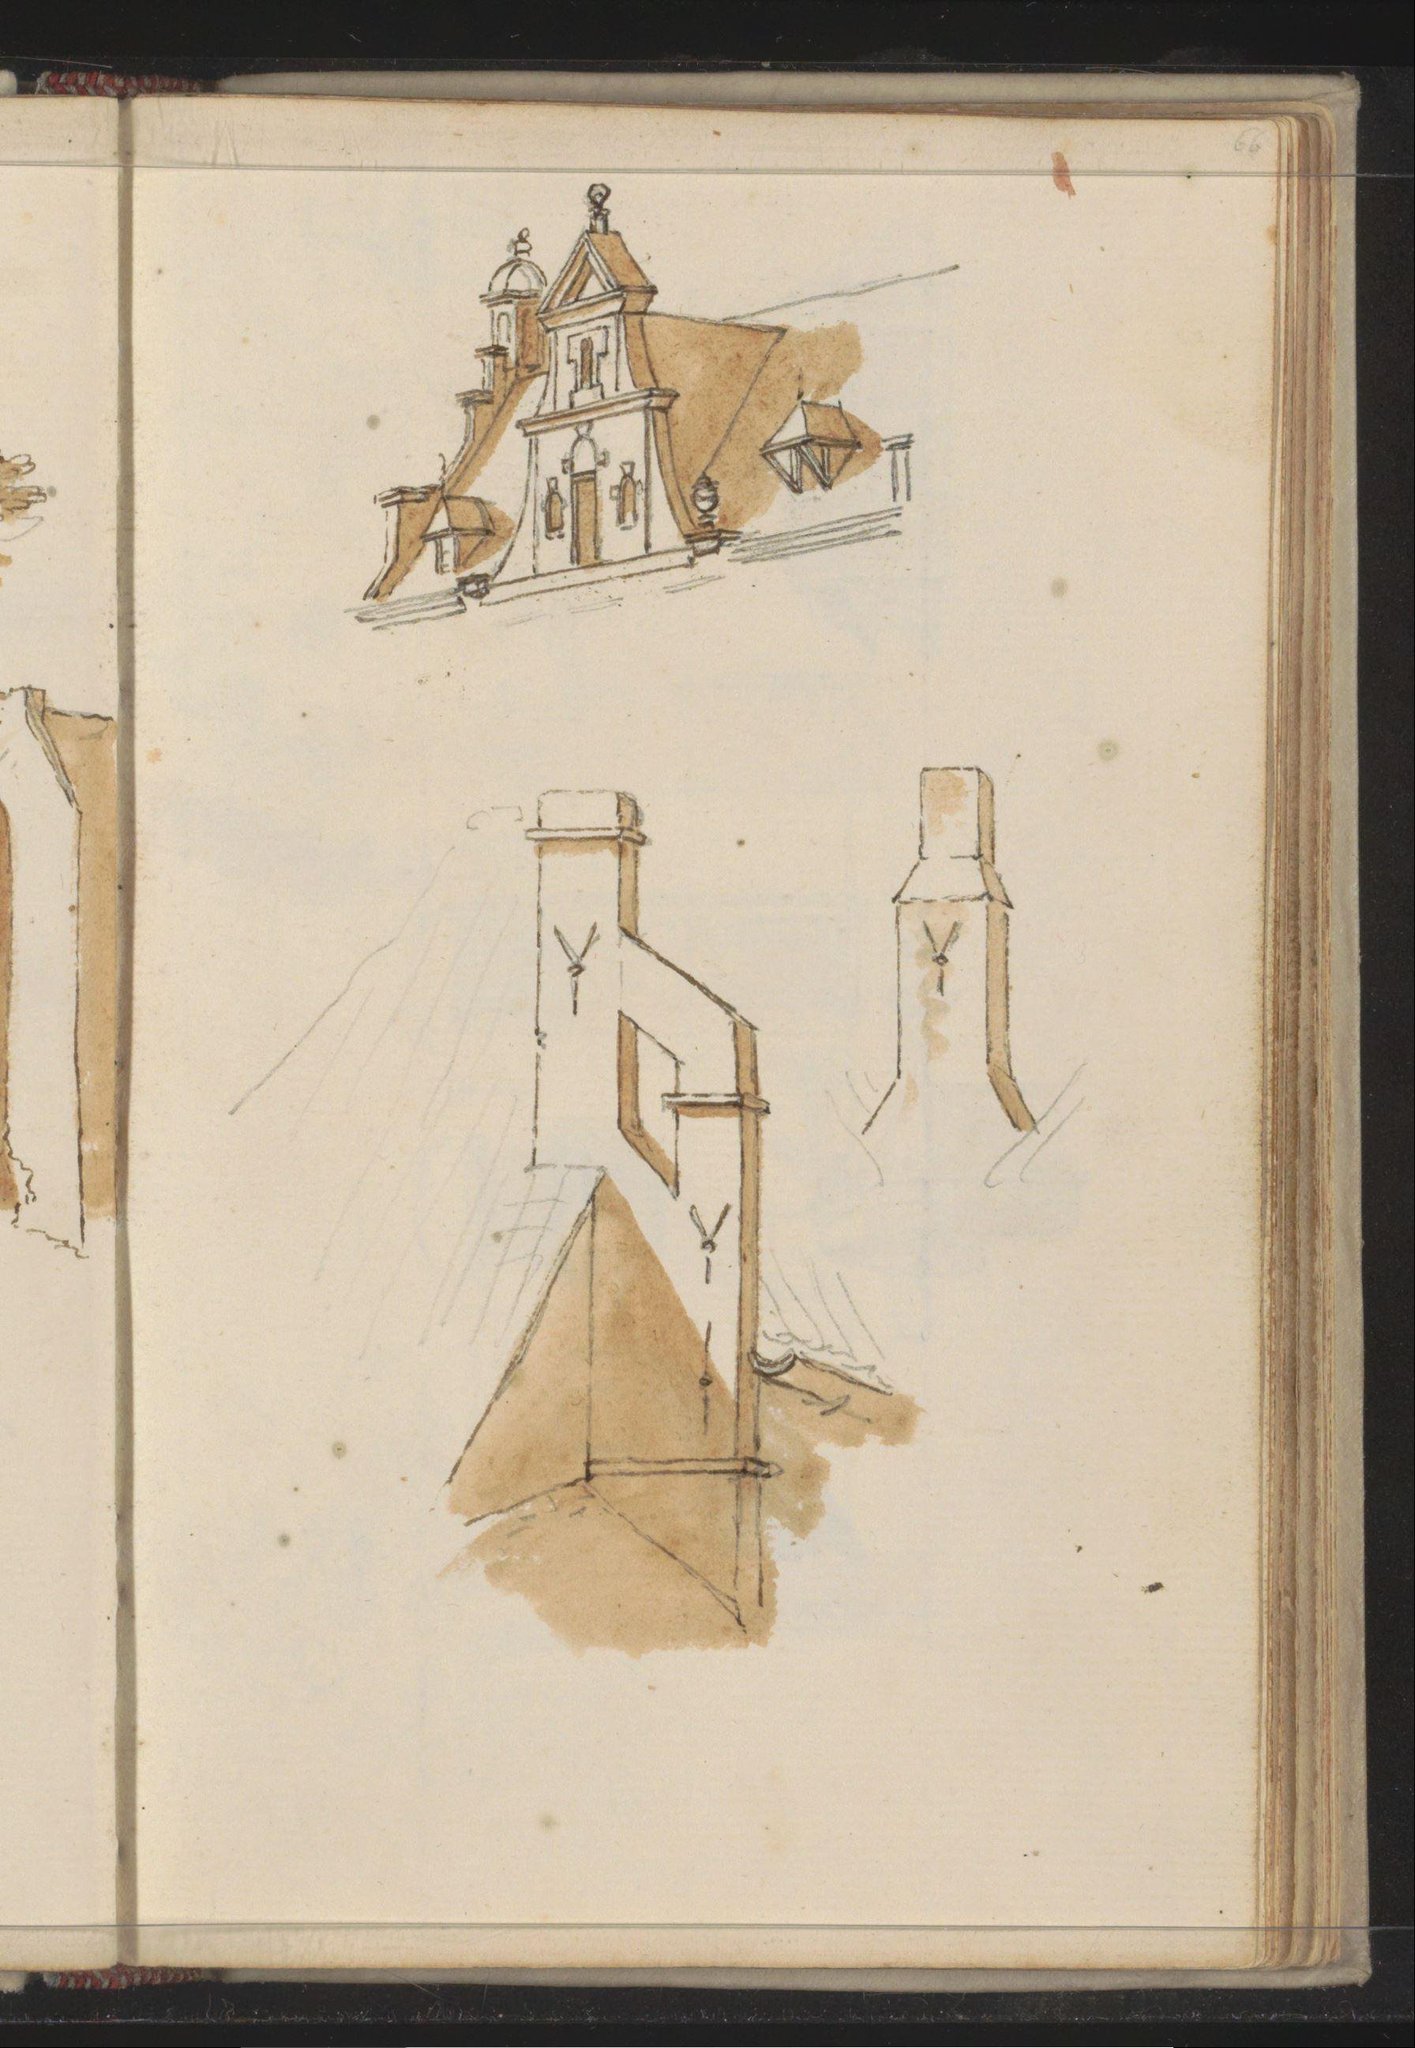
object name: sketchbook leaf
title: Versierde topgevel en schoorstenen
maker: johannes huibert prins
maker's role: draughtsman, painter, print maker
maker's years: 1757-1806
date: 1783-1797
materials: ink, paper, pencil, watercolor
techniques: brush, pen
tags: chimney, decorated gable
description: Pagina 66 uit een schetsboek met 175 pagina's.